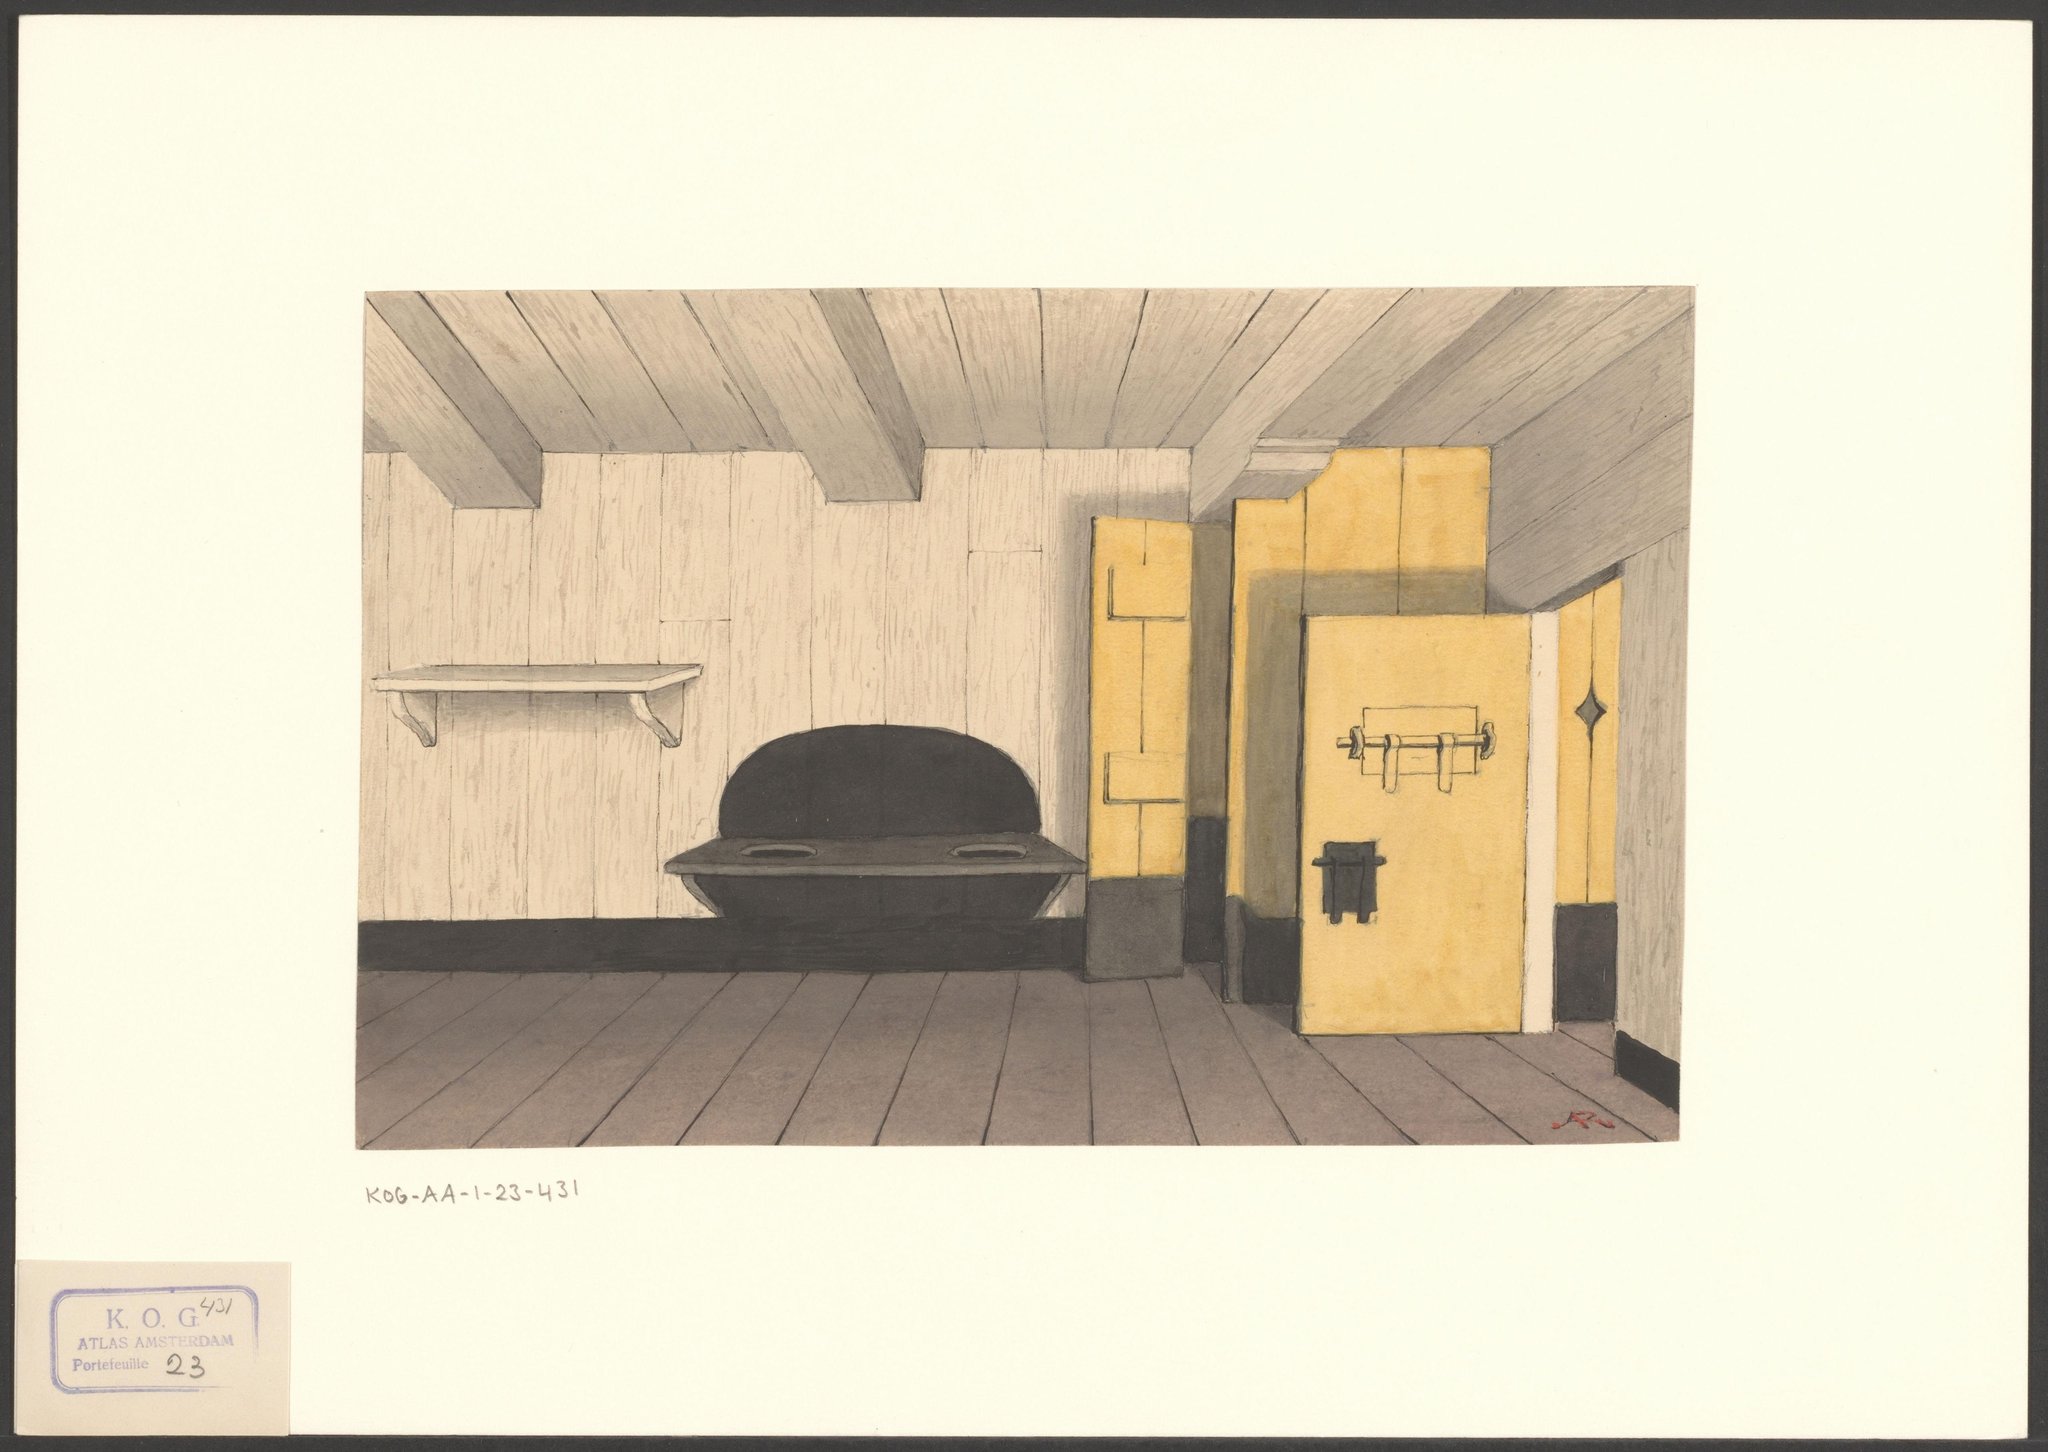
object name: drawing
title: Interieur van een cel in het Tucht- of Rasphuis aan de Heiligeweg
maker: johan martinus anthon rieke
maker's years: 1851-1899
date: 1895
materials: gouache, ink, paper, pencil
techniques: brush, pen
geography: amsterdam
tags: prison, jail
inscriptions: stamp: ‘K.O.G.’, signature, date and inscription: ‘Cel in het (...) fec 1895 Amsterdam’, signature (false): ‘JMAR’, collector's mark: ‘23’ Lugt 1641b, inscription: ‘Port. 23-431’, collector's mark: Lugt 1641a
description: Onderwerpsrubriek binnen de Atlas Amsterdam: Handvesten, Keuren, enz.; Rechtswezen (incl. gevangenissen, enz.).